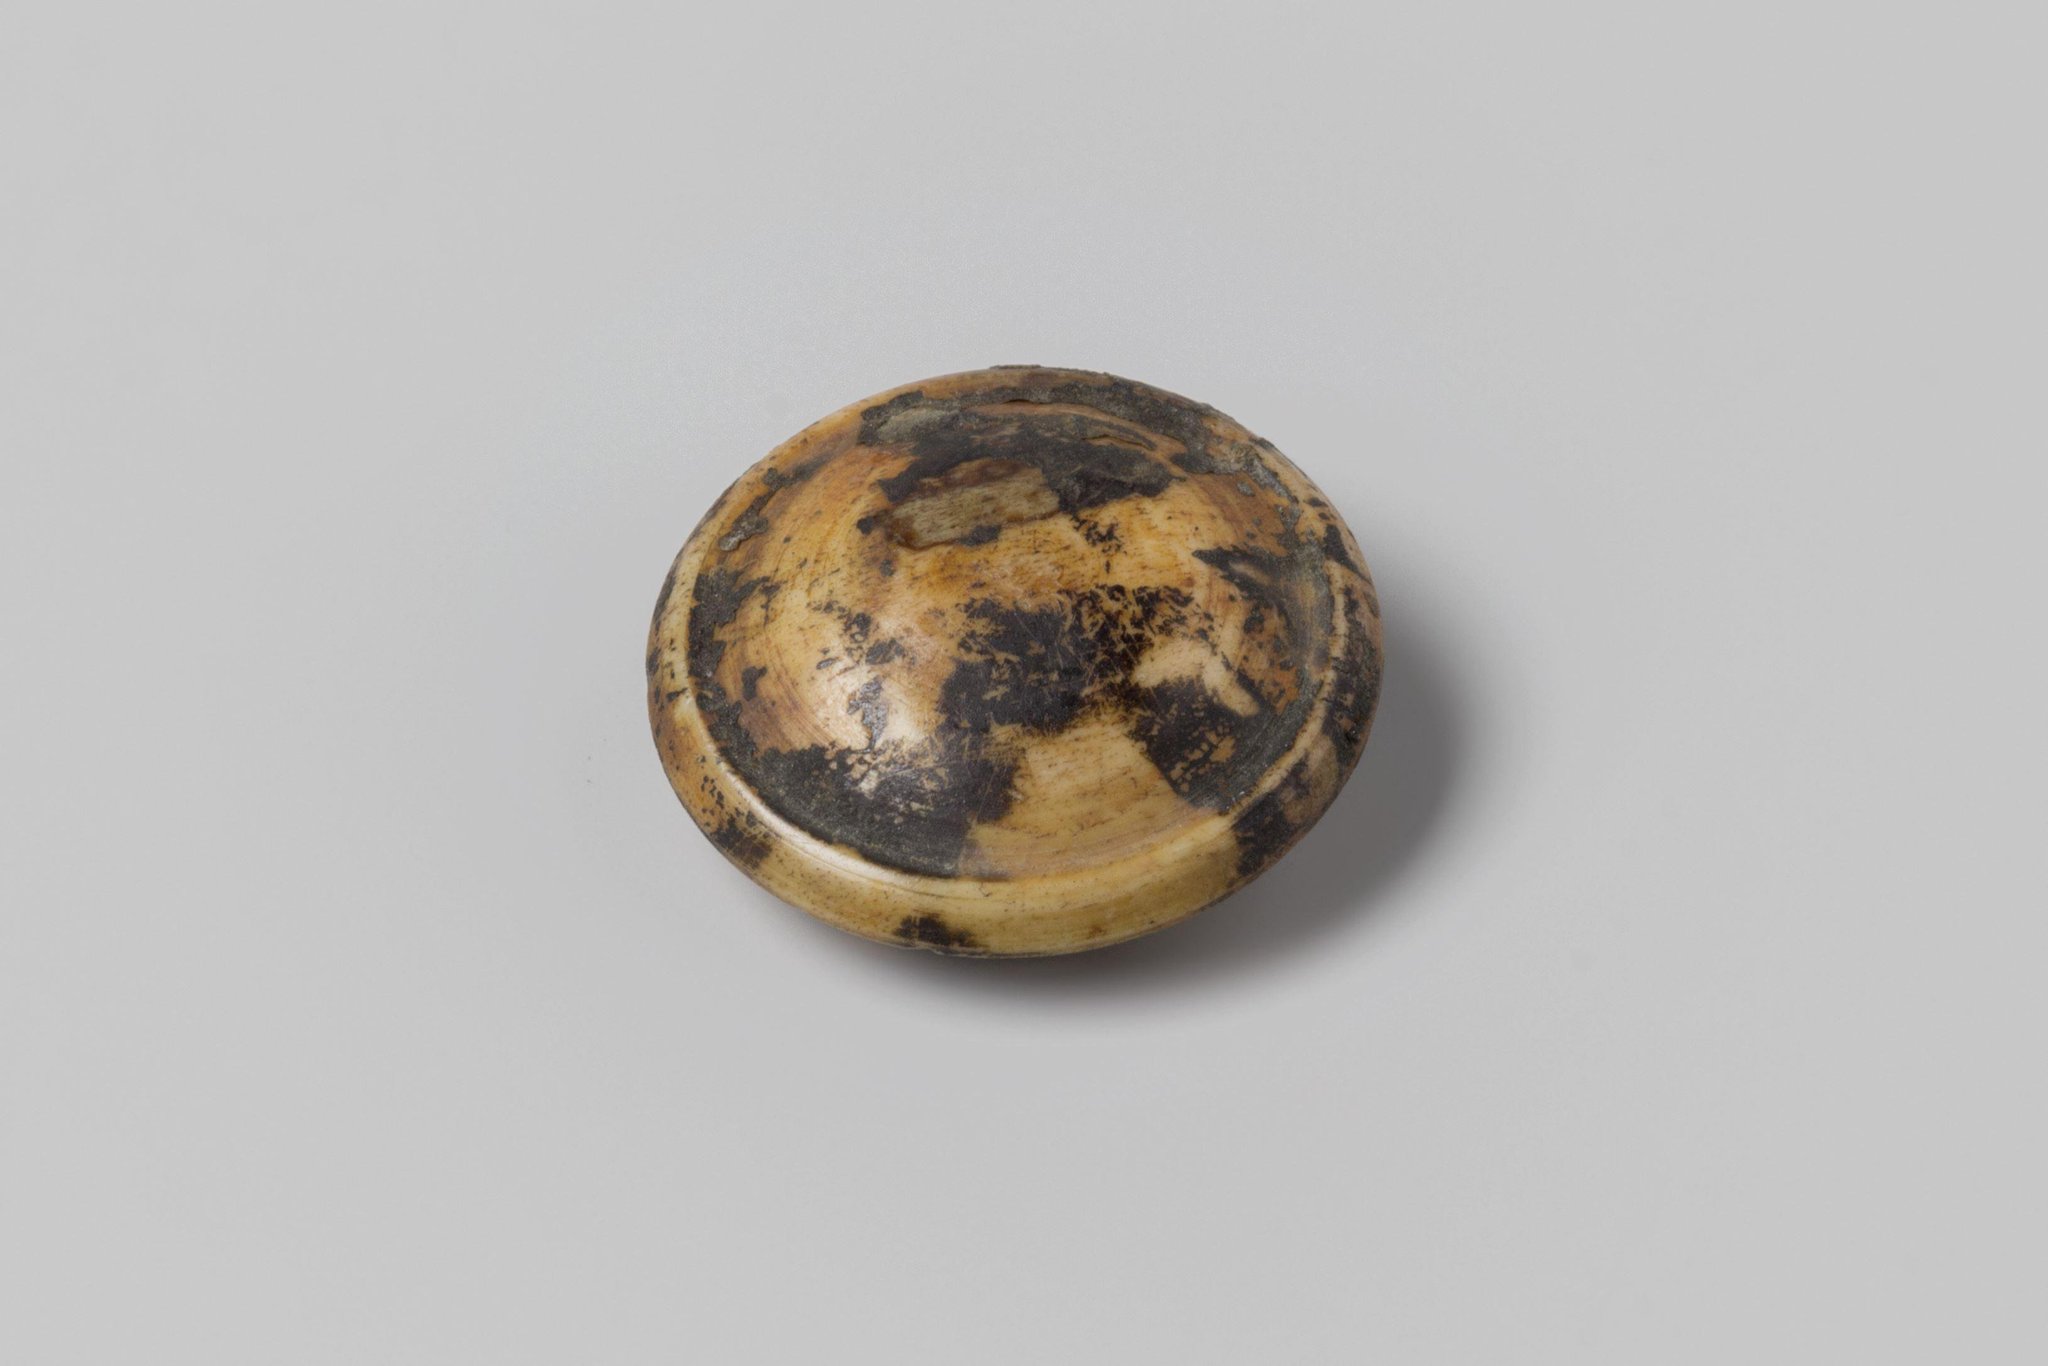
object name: button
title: Knoop uit het wrak van de Oost-Indiëvaarder Hollandia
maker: Anonymous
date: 1700-1743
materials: bone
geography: netherlands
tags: verenigde oostindische compagnie, hollandia (schip), annet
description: Knoop. (1) sim. NG 1980-27H1185 (1.7, 1.8d)